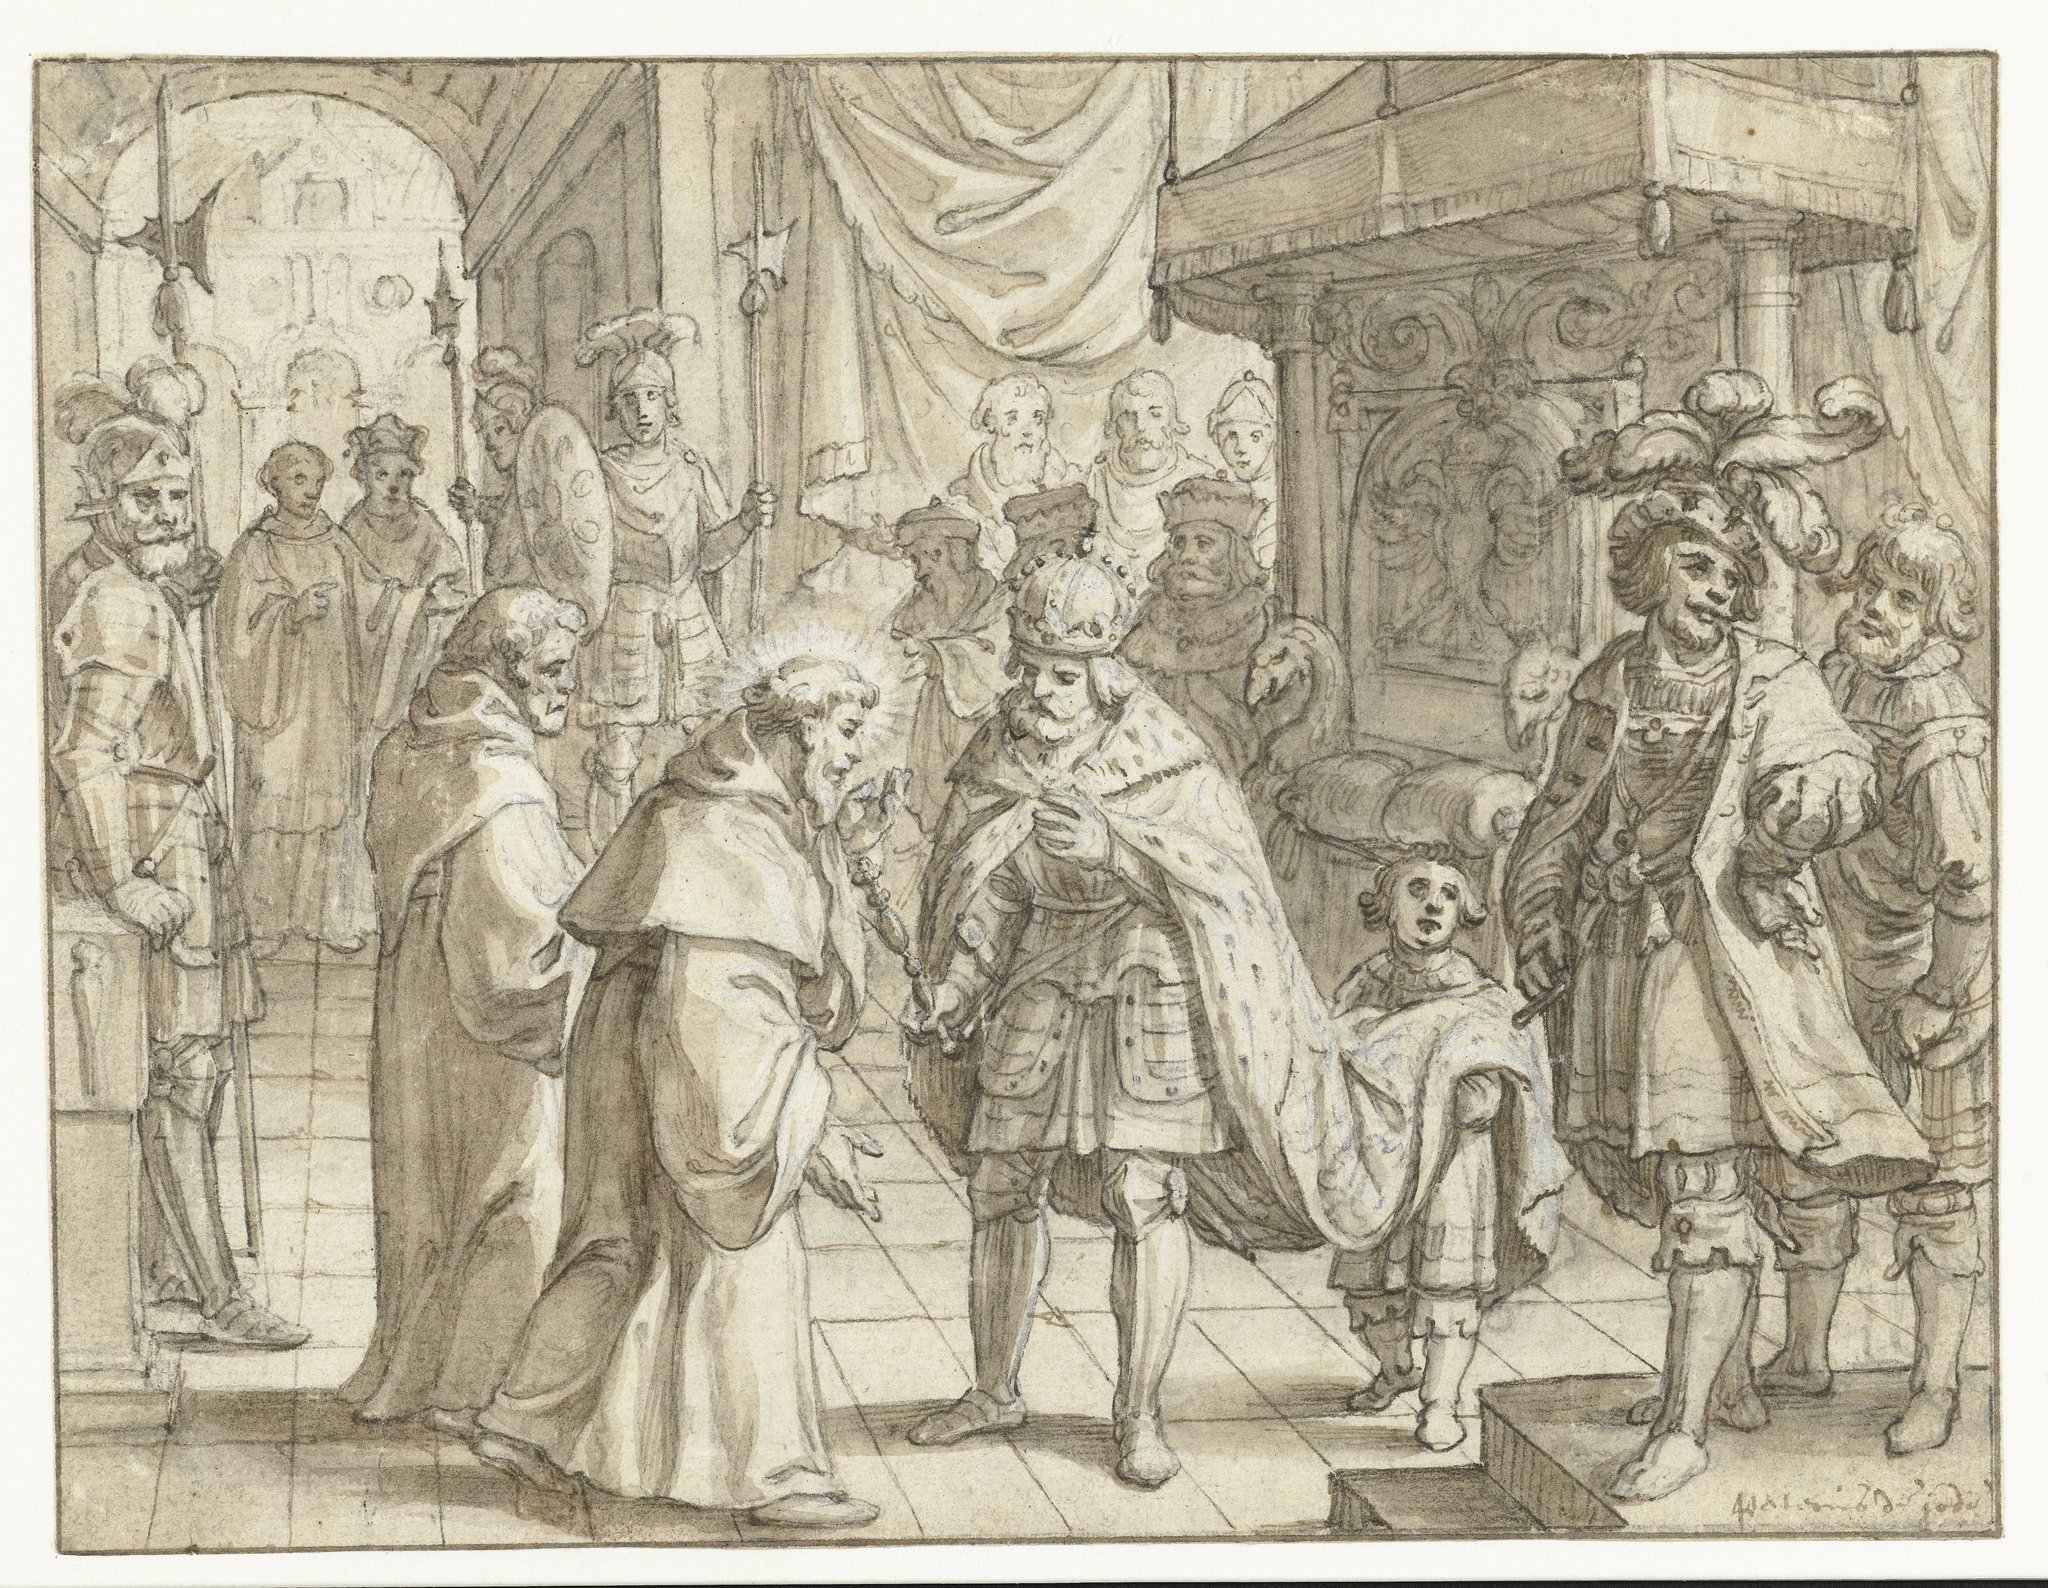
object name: design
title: Heilige monnik op audiëntie bij een Duitse keizer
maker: pieter de jode (i)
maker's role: draughtsman, print maker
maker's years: 1570-1634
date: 1580-1634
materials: chalk, paint, ink, paper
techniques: brush, pen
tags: monk(s), friar(s)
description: Een heilige monnik, vergezeld van een medebroeder, op audiëntie bij een Duitse keizer. Mogelijk ontwerp voor een prent.